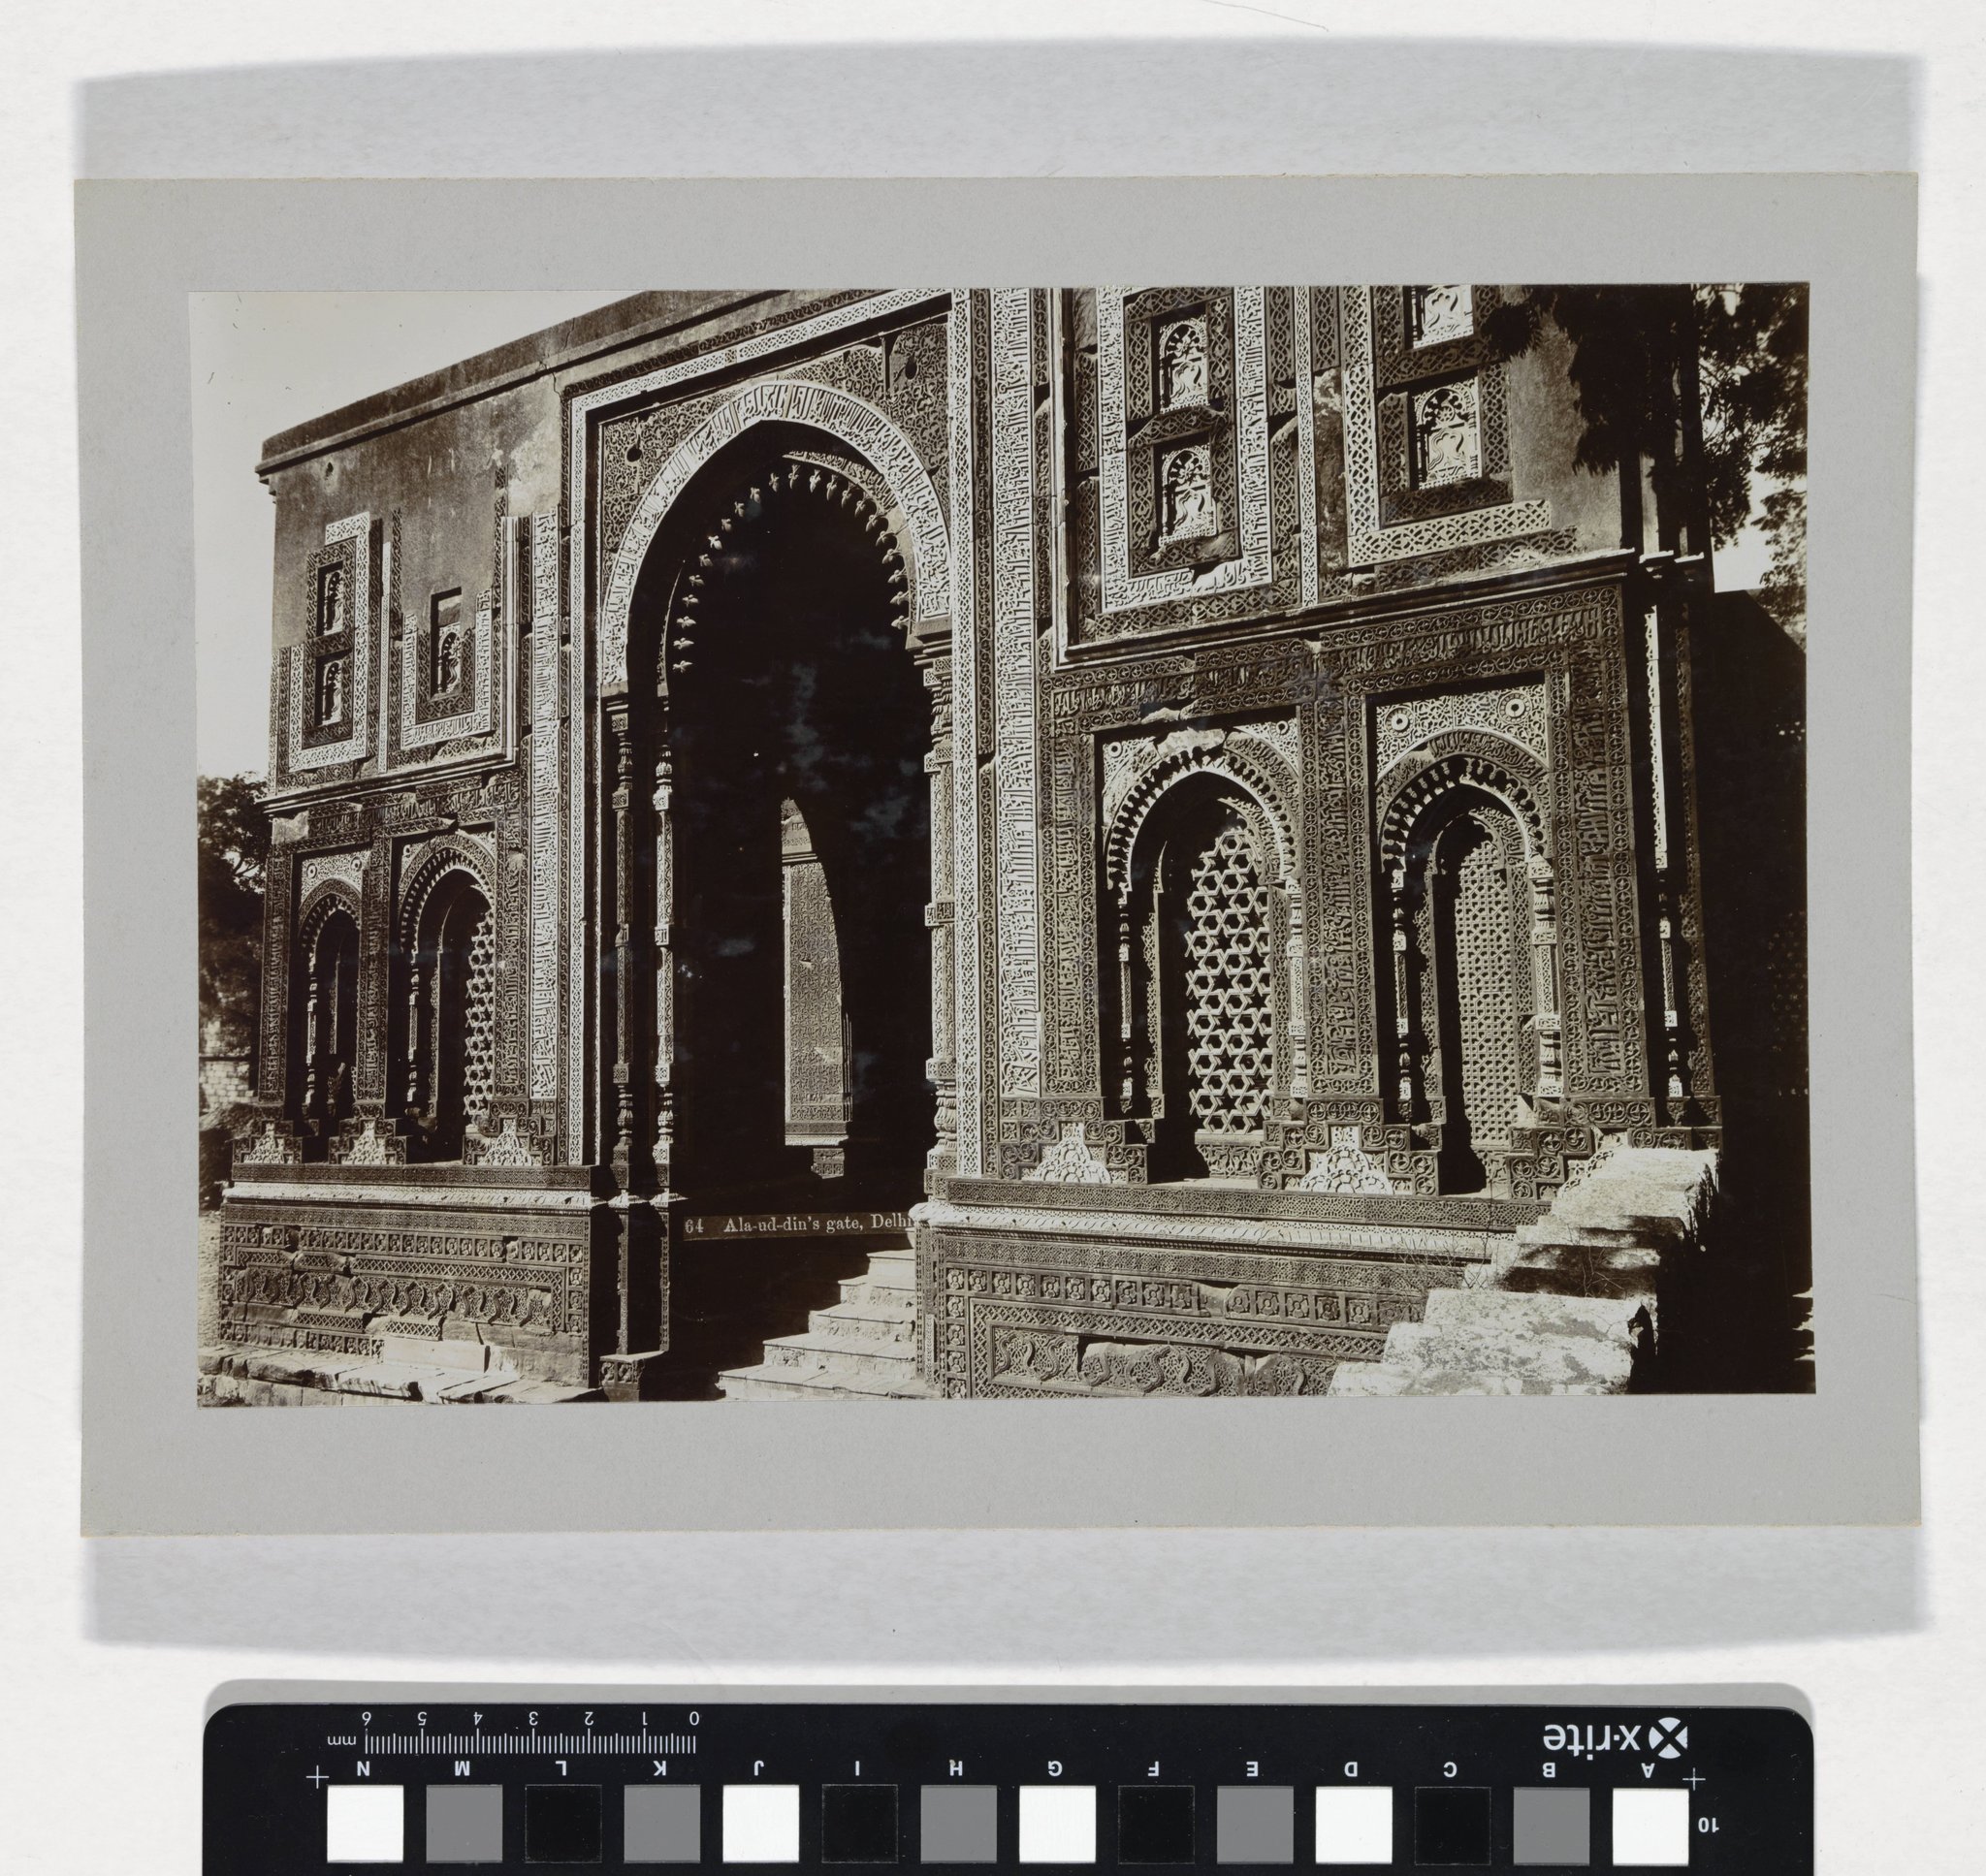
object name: photograph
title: Alai Darwaza, gate at the Qutb Minar, Delhi, India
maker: Anonymous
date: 1895-1915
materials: cardboard, paper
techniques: gelatin silver print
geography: delhi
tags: delhi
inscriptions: inscription: ‘64 Ala-ud-din's gate, Delhi.’, annotation: ‘42. Poort bij Kutab Minar.’